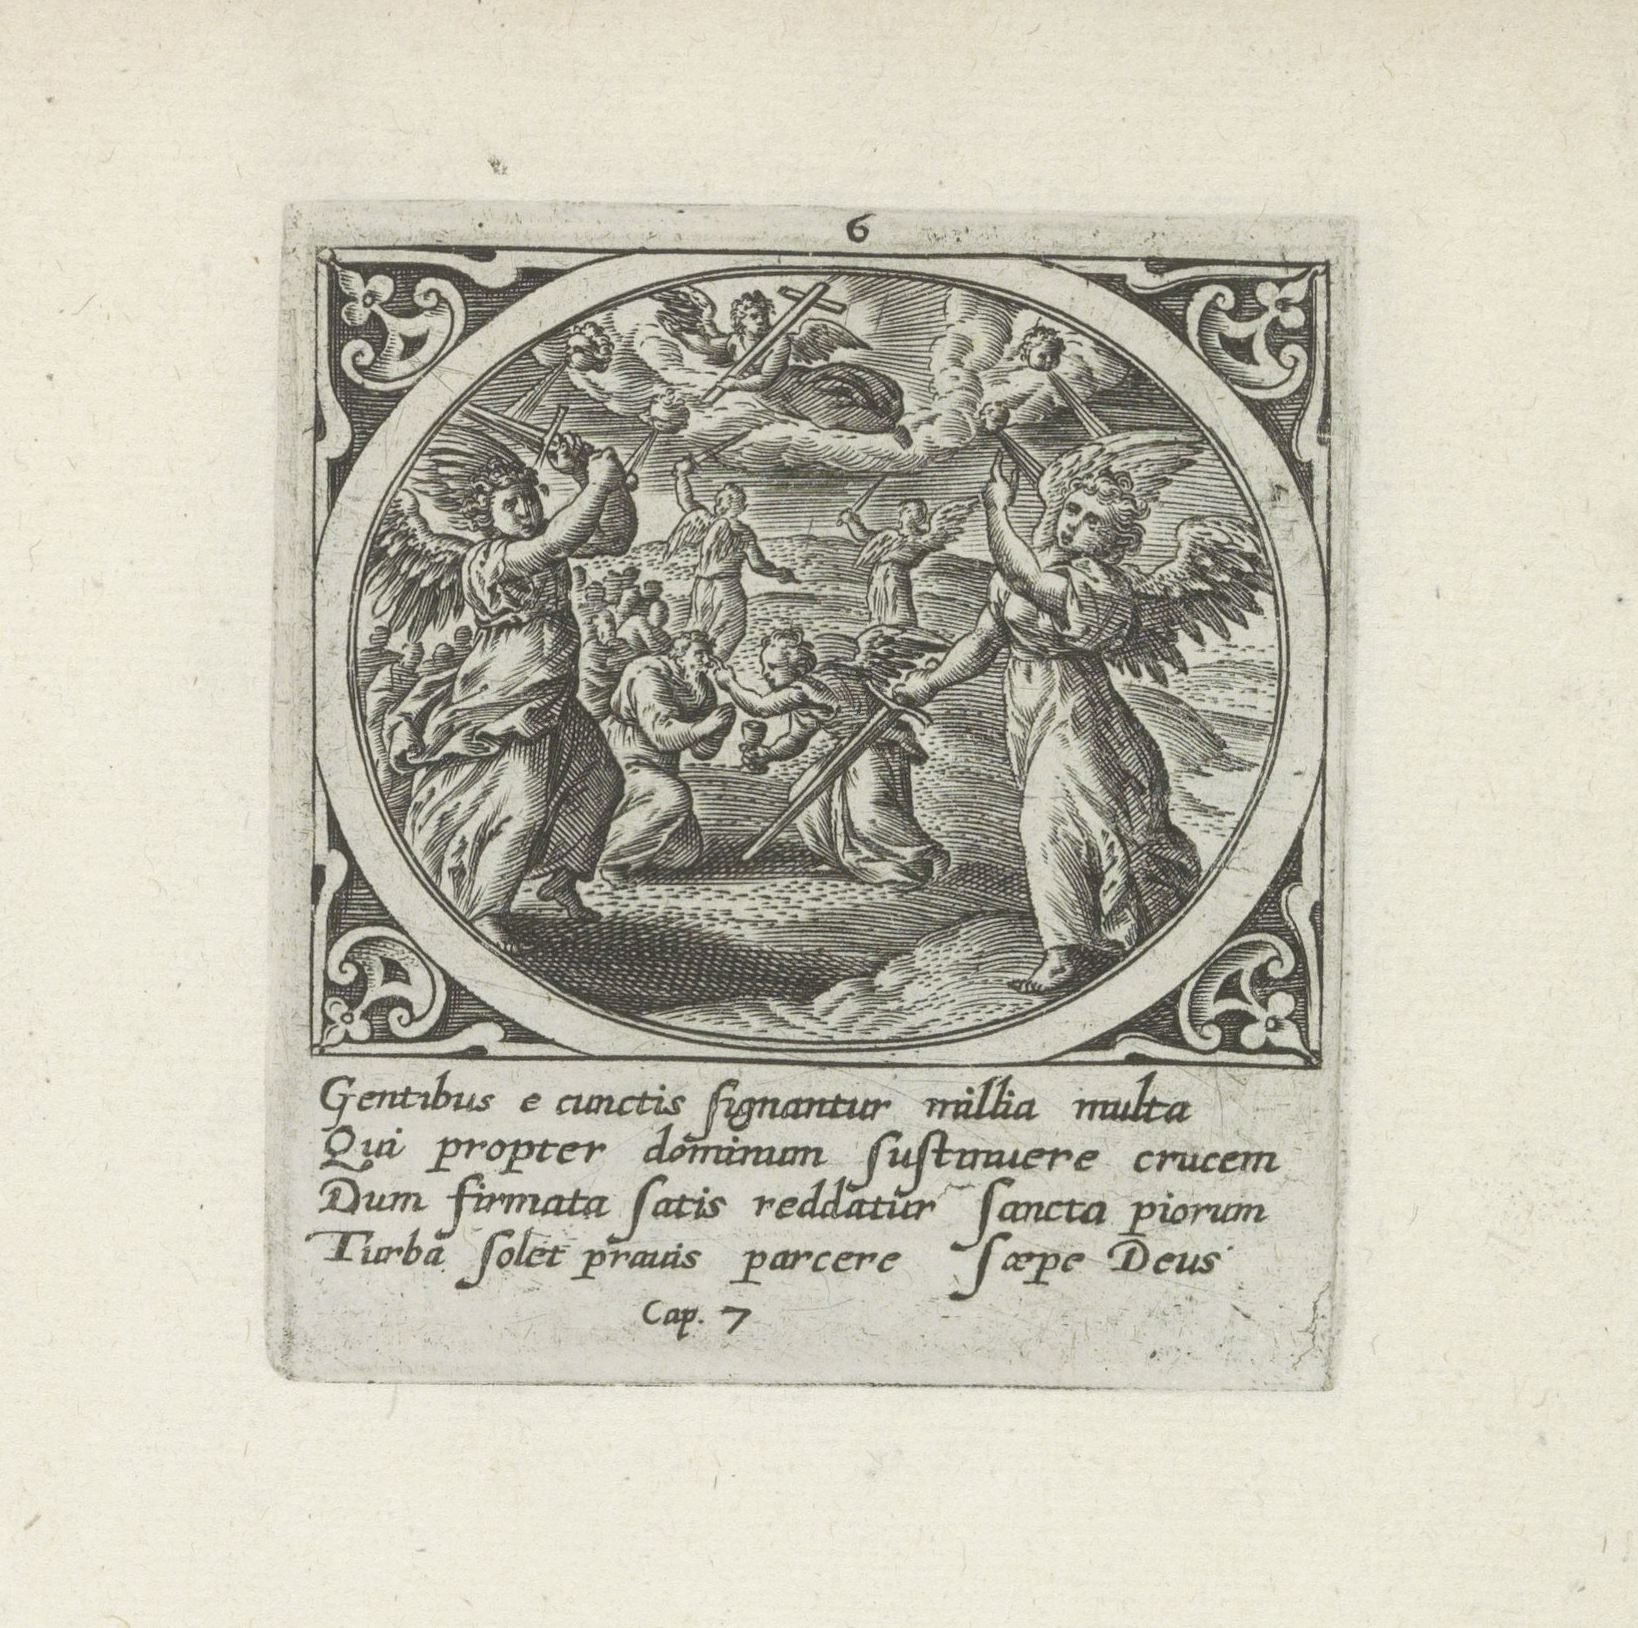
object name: album leaf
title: Openbaring van Johannes op Patmos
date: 1585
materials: paper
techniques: engraving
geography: antwerp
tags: the four winds are restrained by four angels, sealing of the tribes of israel, the 144-thousand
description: Vier engelen houden met hun zwaard de vier winden in bedwang. In het midden brengt een engel het zegel van God aan op het voorhoofd van een lid van een stam van Israël. Boven in de wolken een engel met een kruis. Onder de voorstelling een verwijzing in het Latijn naar de Bijbeltekst in Op. 7. Deze prent maakt deel uit van een album.